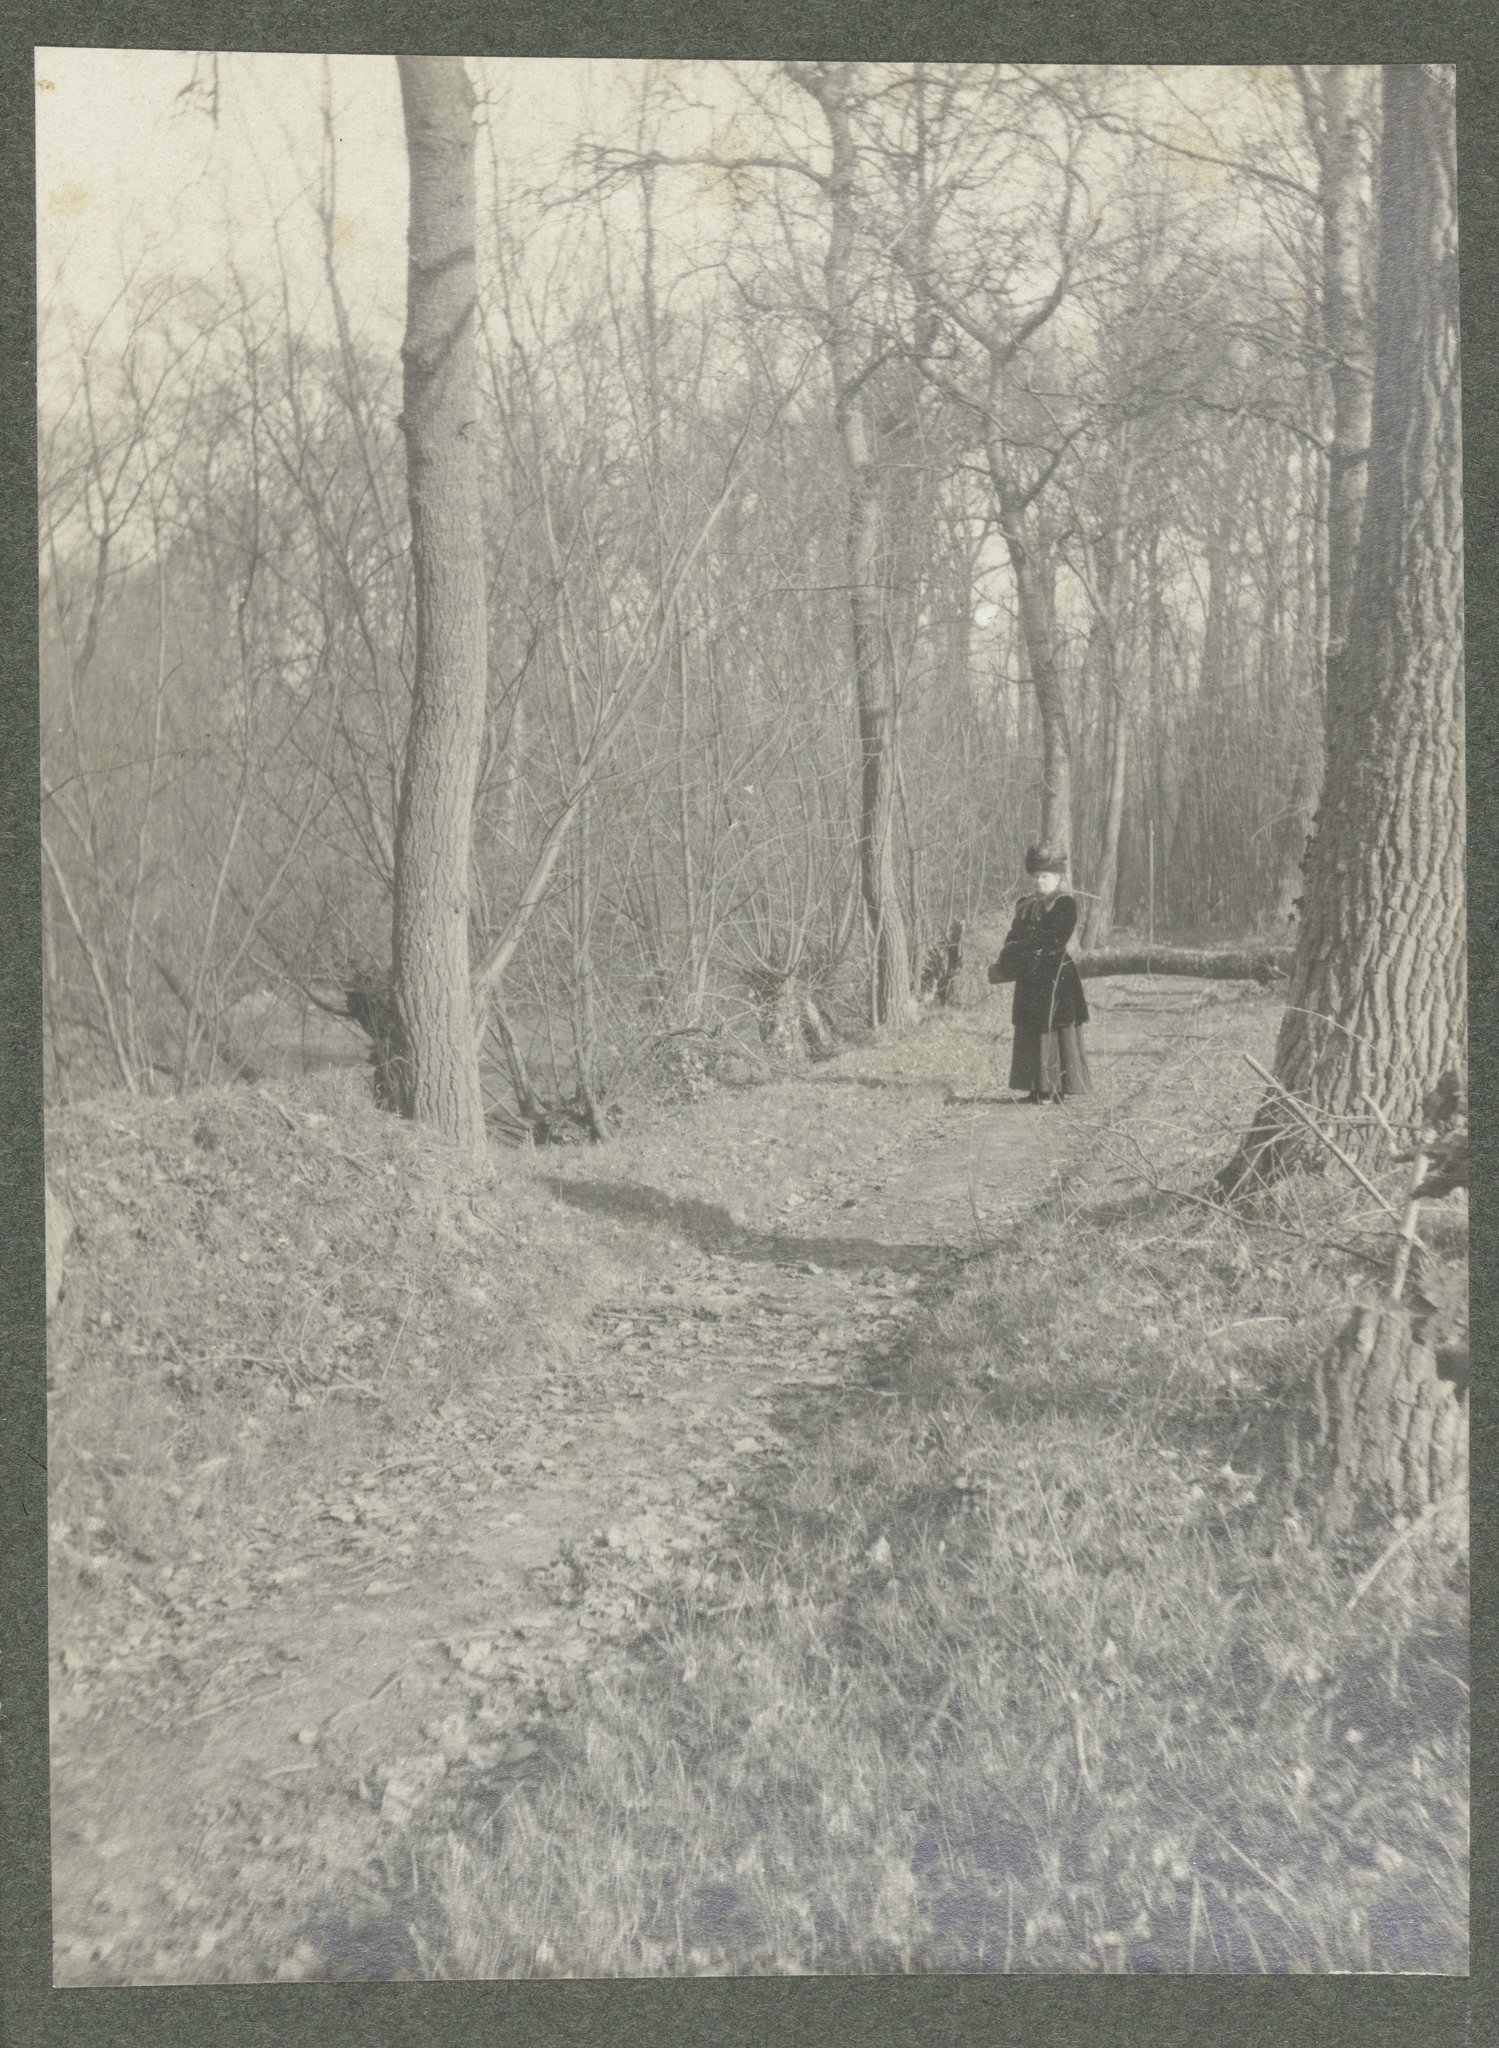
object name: photograph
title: Margo J.J. Kessler-de Lange op een bospad op landgoed De Pauw in Wassenaar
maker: geldolph adriaan kessler (dolph)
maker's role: fotograaf, industrieel, voetballer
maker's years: 1884-1945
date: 1913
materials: paper, photographic support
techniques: gelatin silver print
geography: wassenaar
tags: huize de paauw